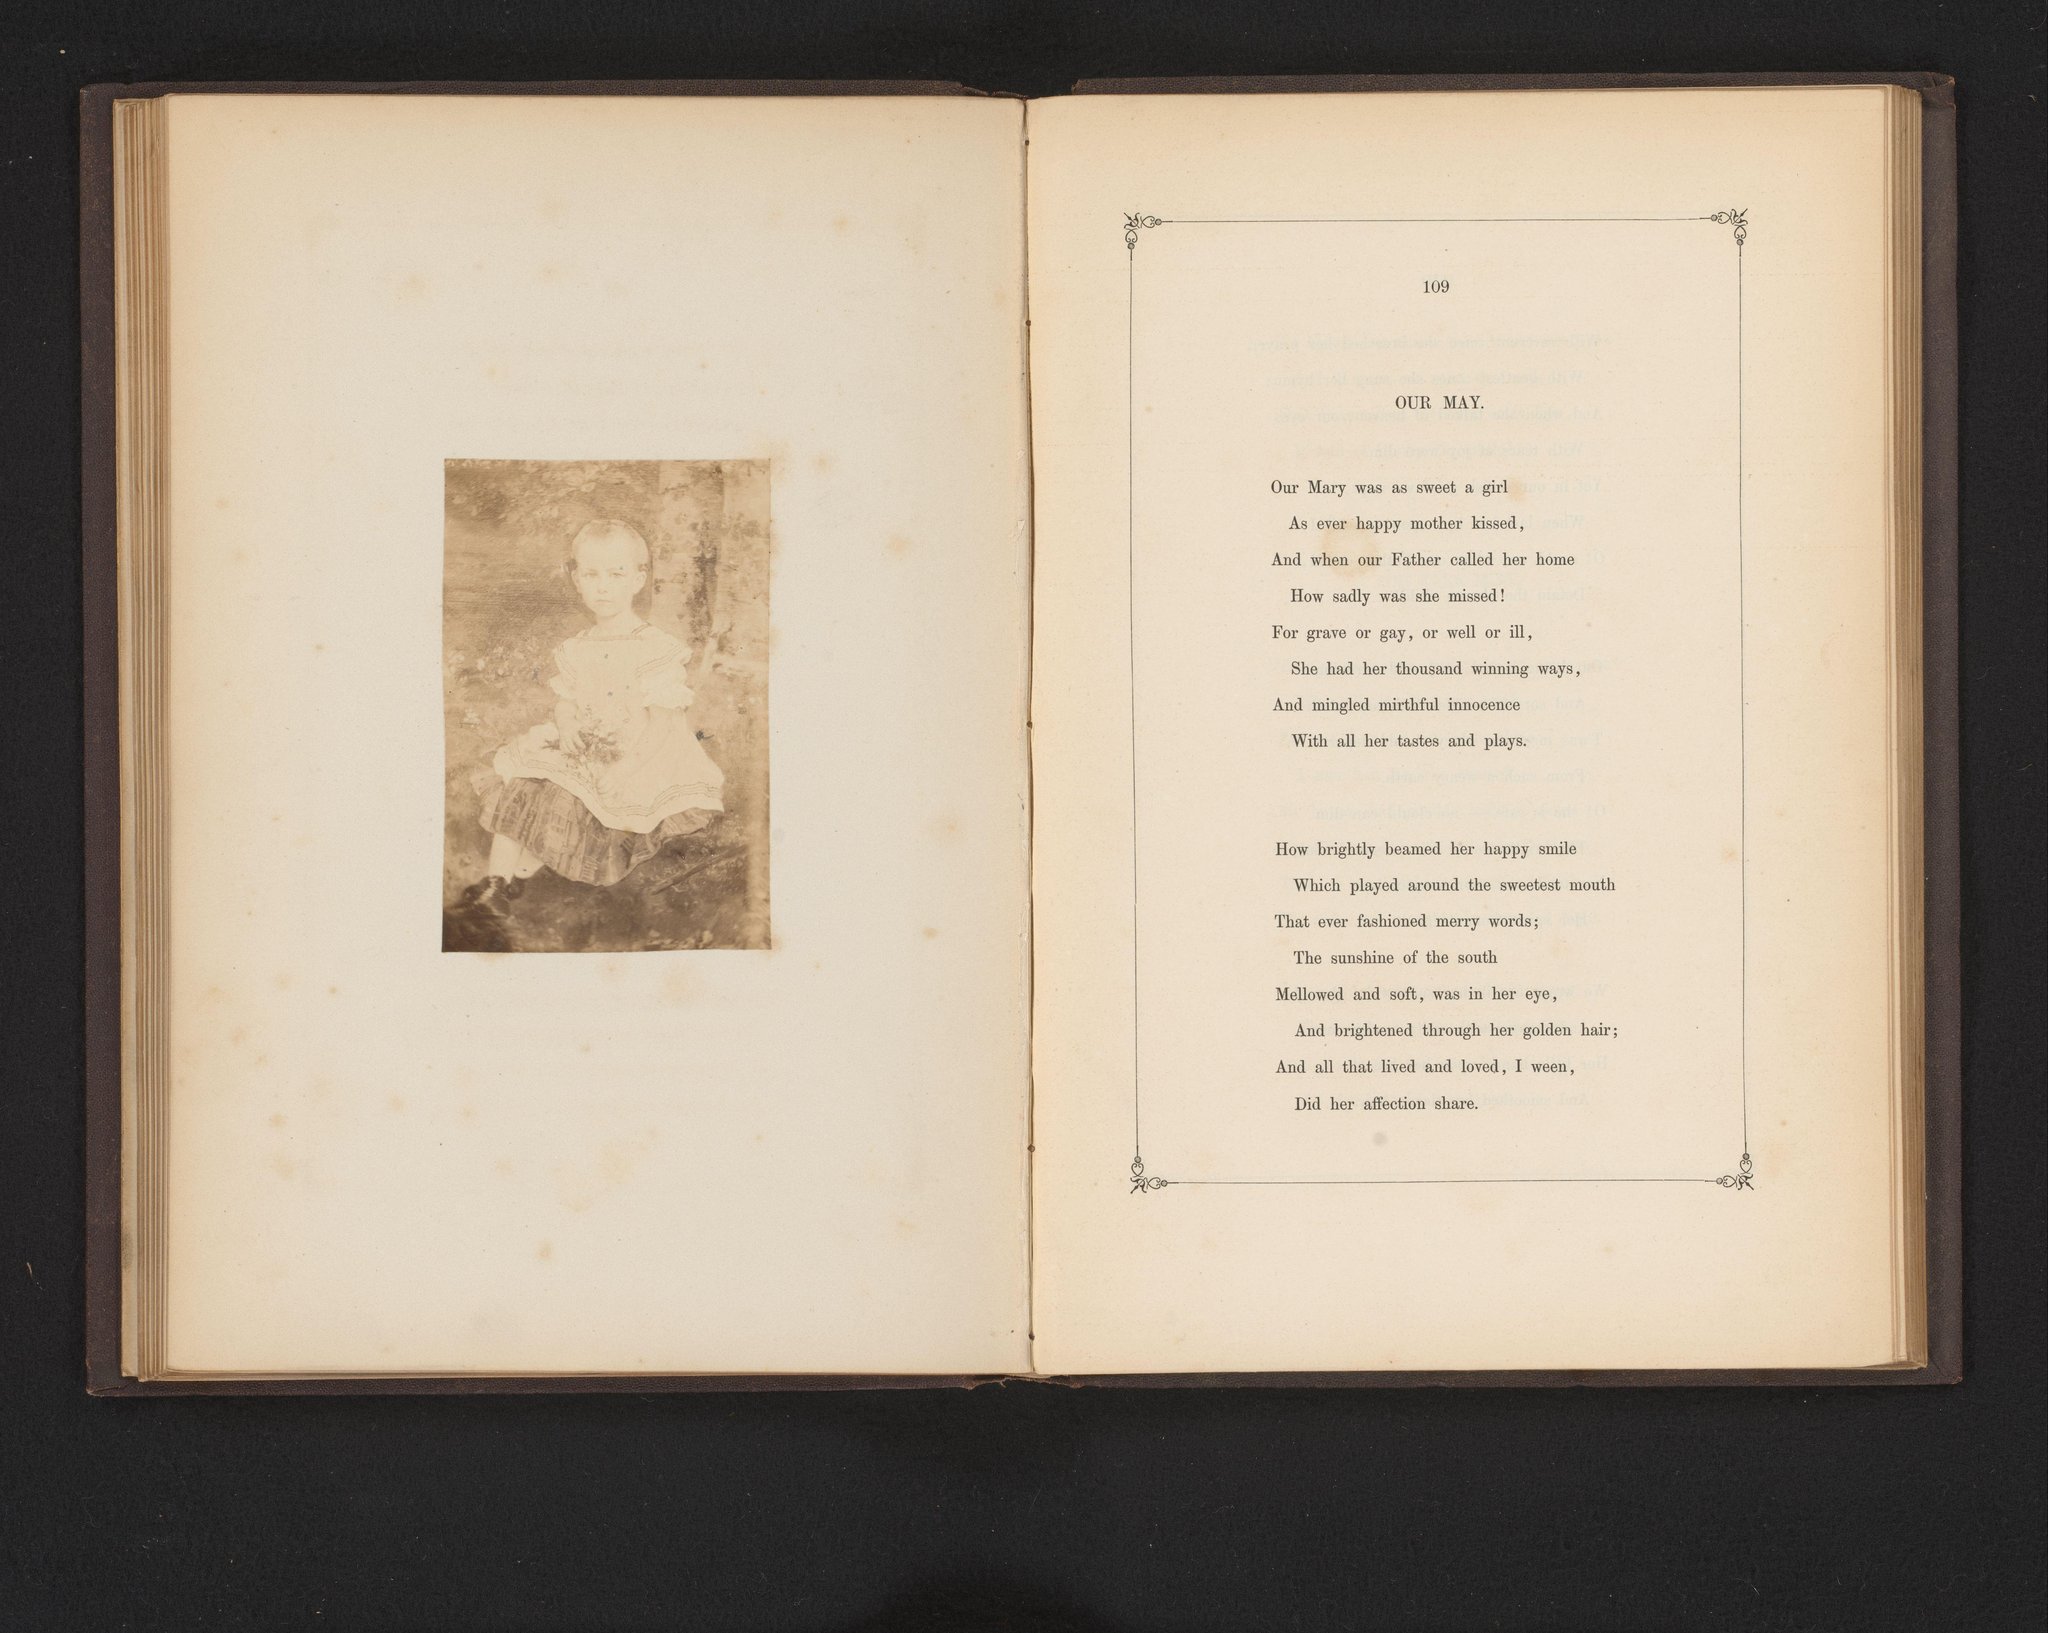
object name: photograph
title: Portret van een onbekend meisje, aangeduid als May, met bloemen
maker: Anonymous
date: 1860-1865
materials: paper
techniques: albumen print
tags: historical persons, girl (child between toddler and youth)